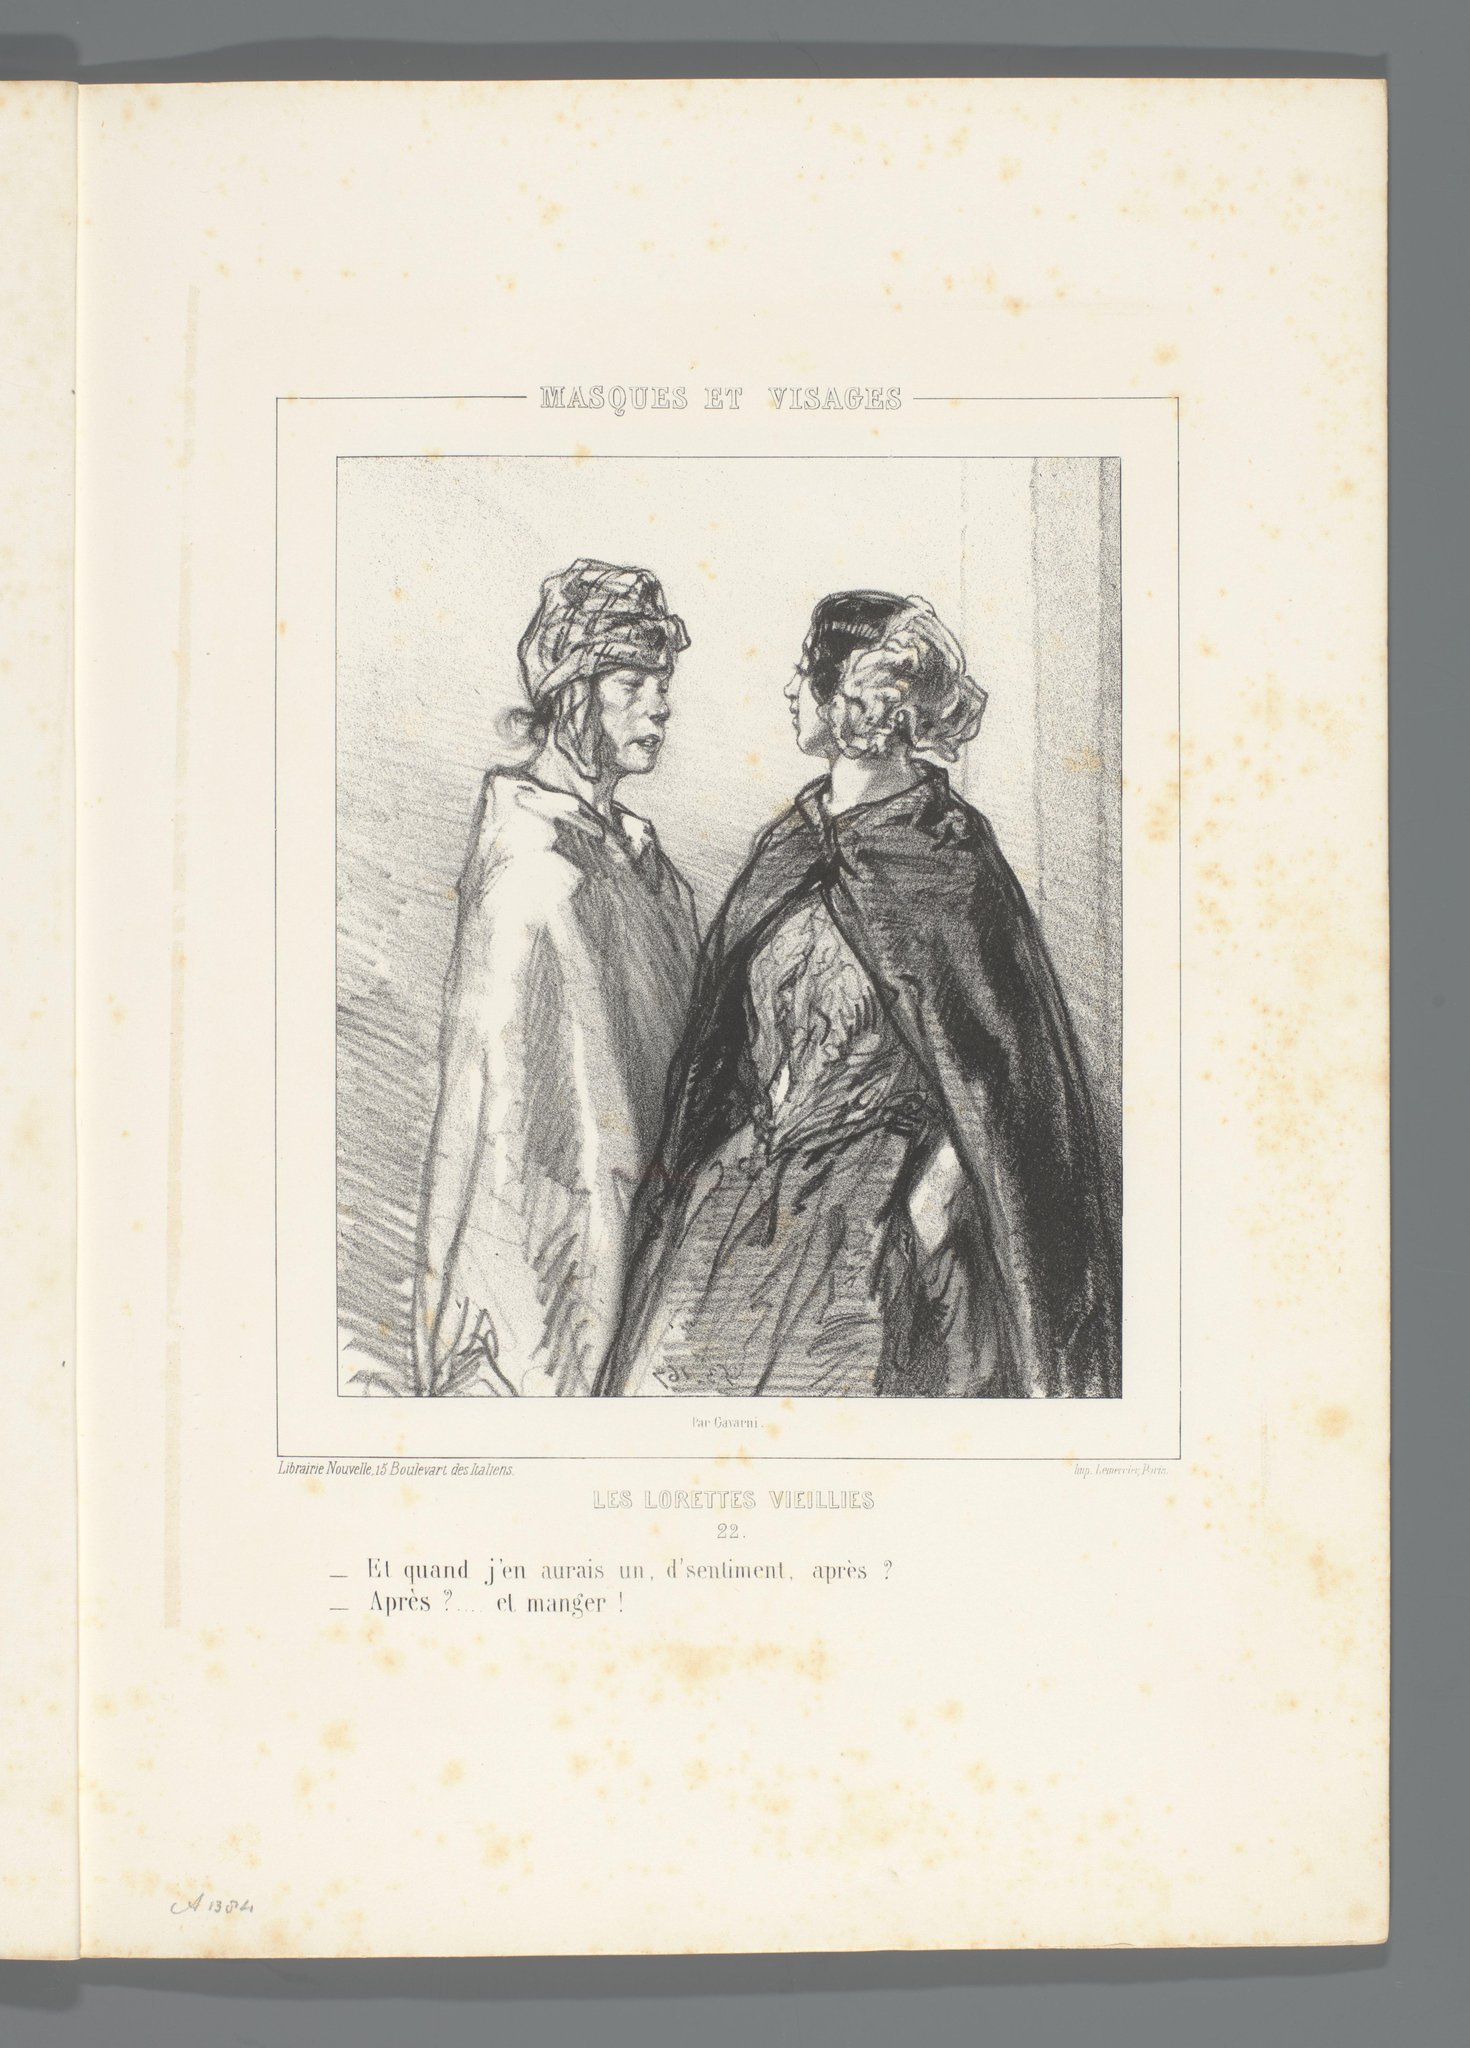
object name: print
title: Oude vrouw geeft jonge vrouw advies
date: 1853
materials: paper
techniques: lithograph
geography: paris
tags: adult woman, old woman, whore, prostitute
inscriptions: collector's mark: Lugt 964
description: Prent gebruikt voor: Paris (Journal), 26 november 1853.